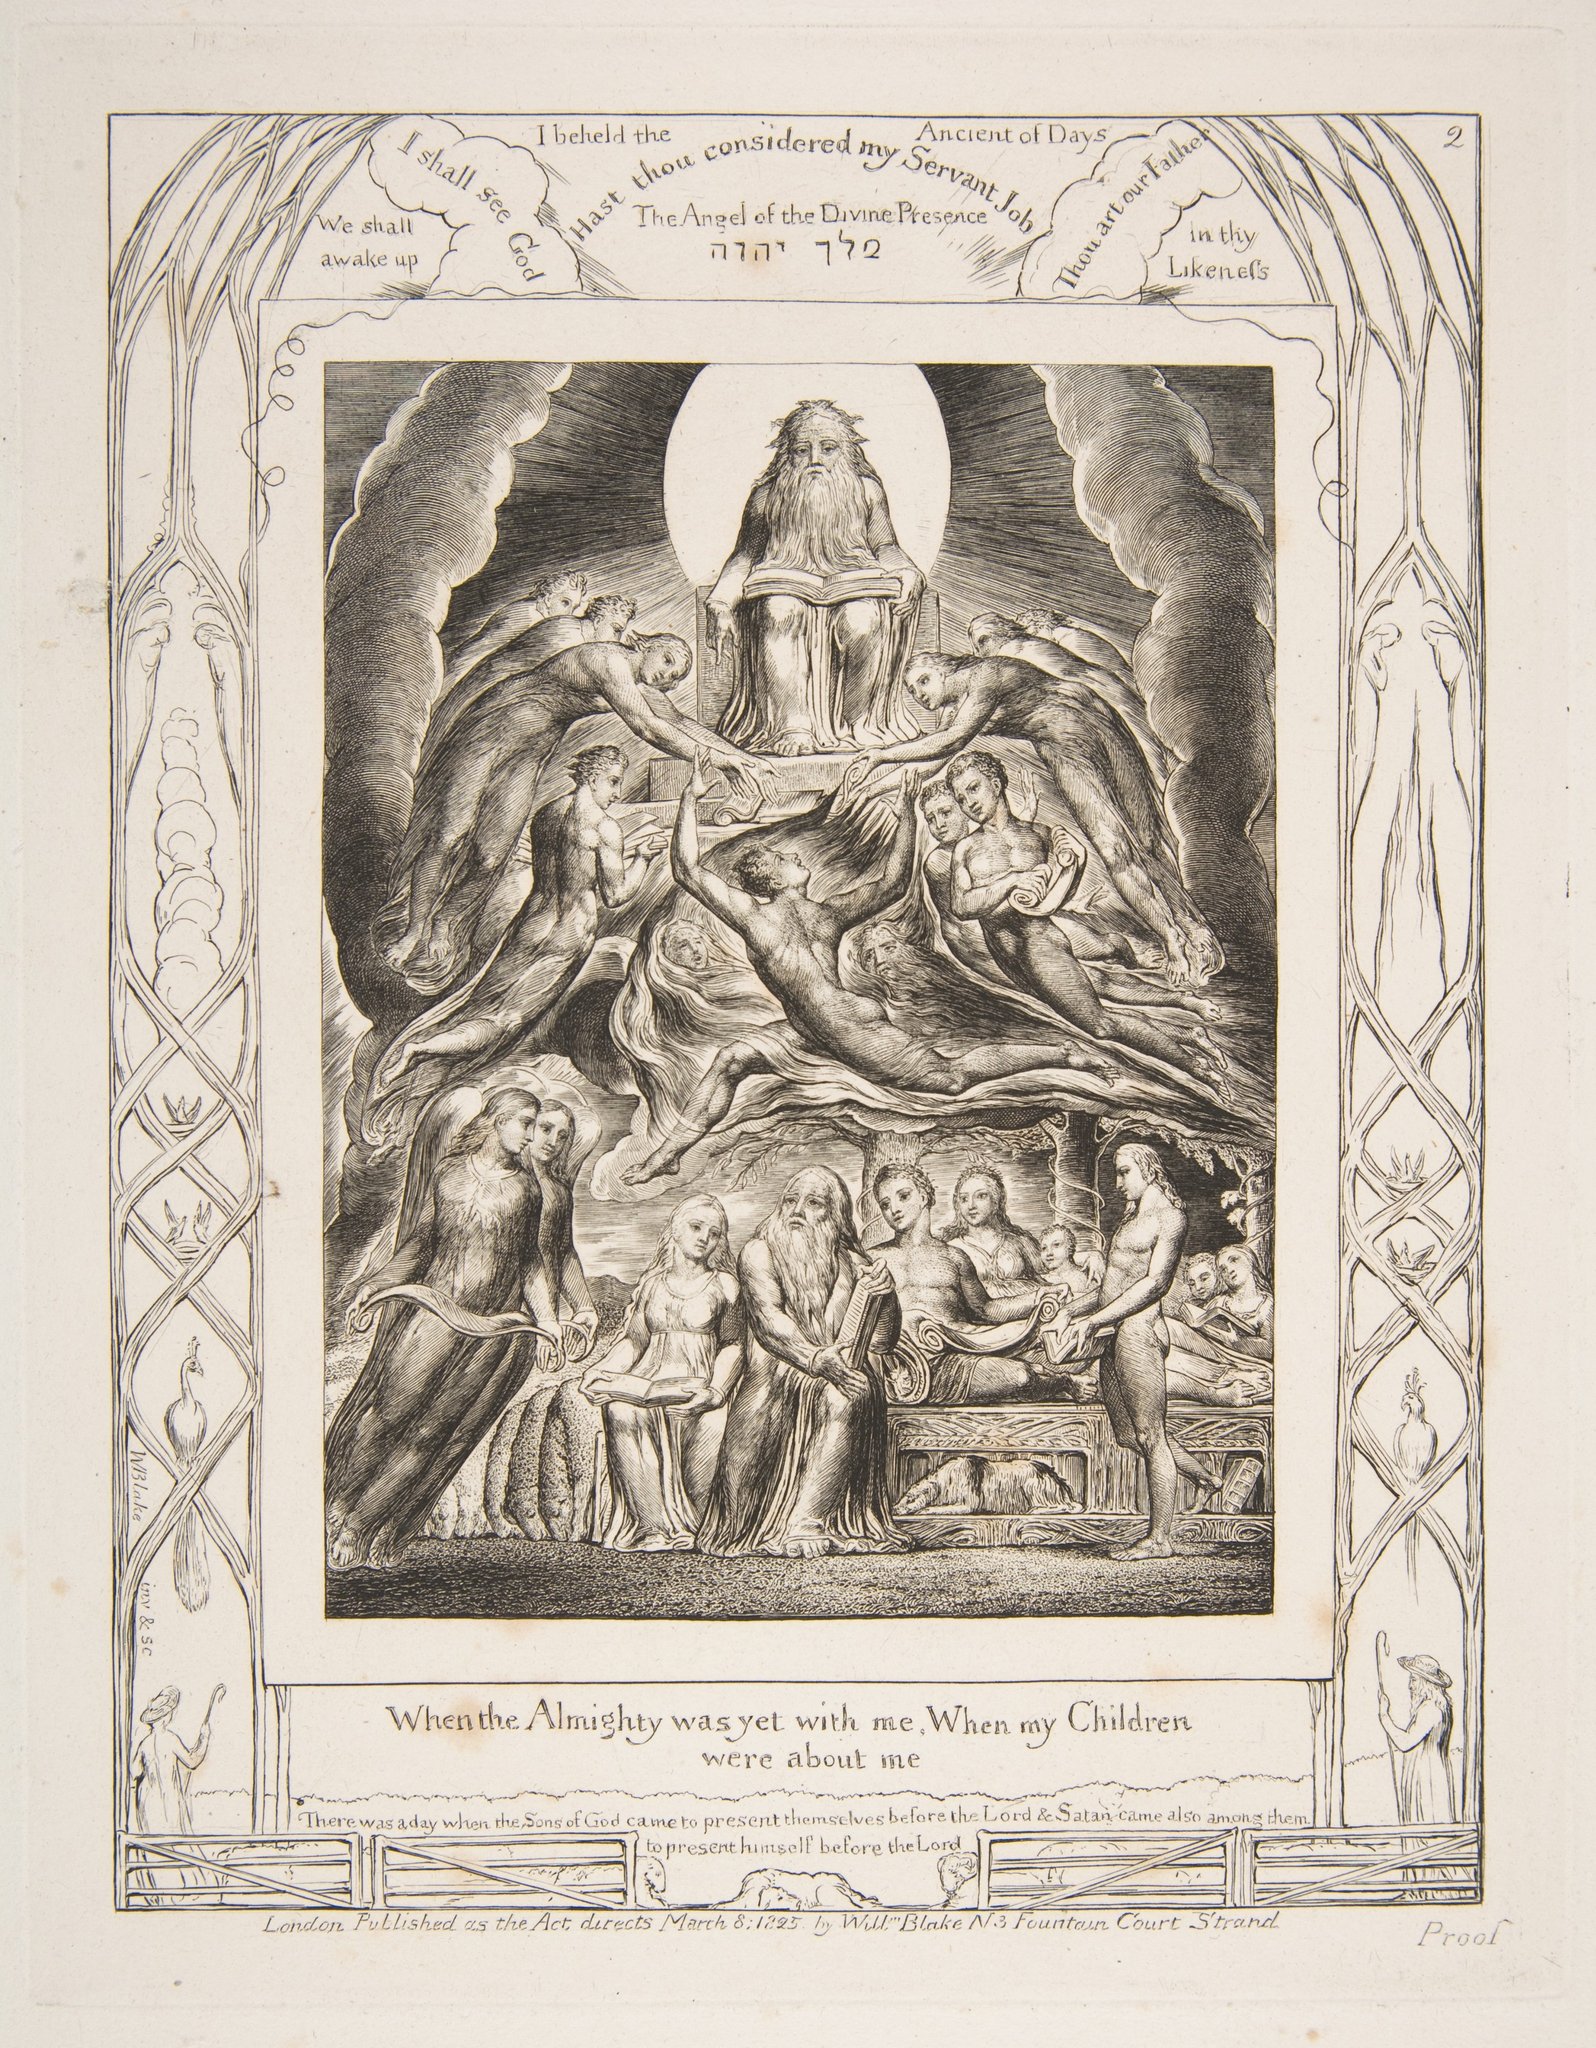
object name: print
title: Satan Before the Throne of God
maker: william blake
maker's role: artist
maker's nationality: british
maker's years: 1757-1827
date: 1825-1826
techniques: engraving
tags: men,angels,god the father